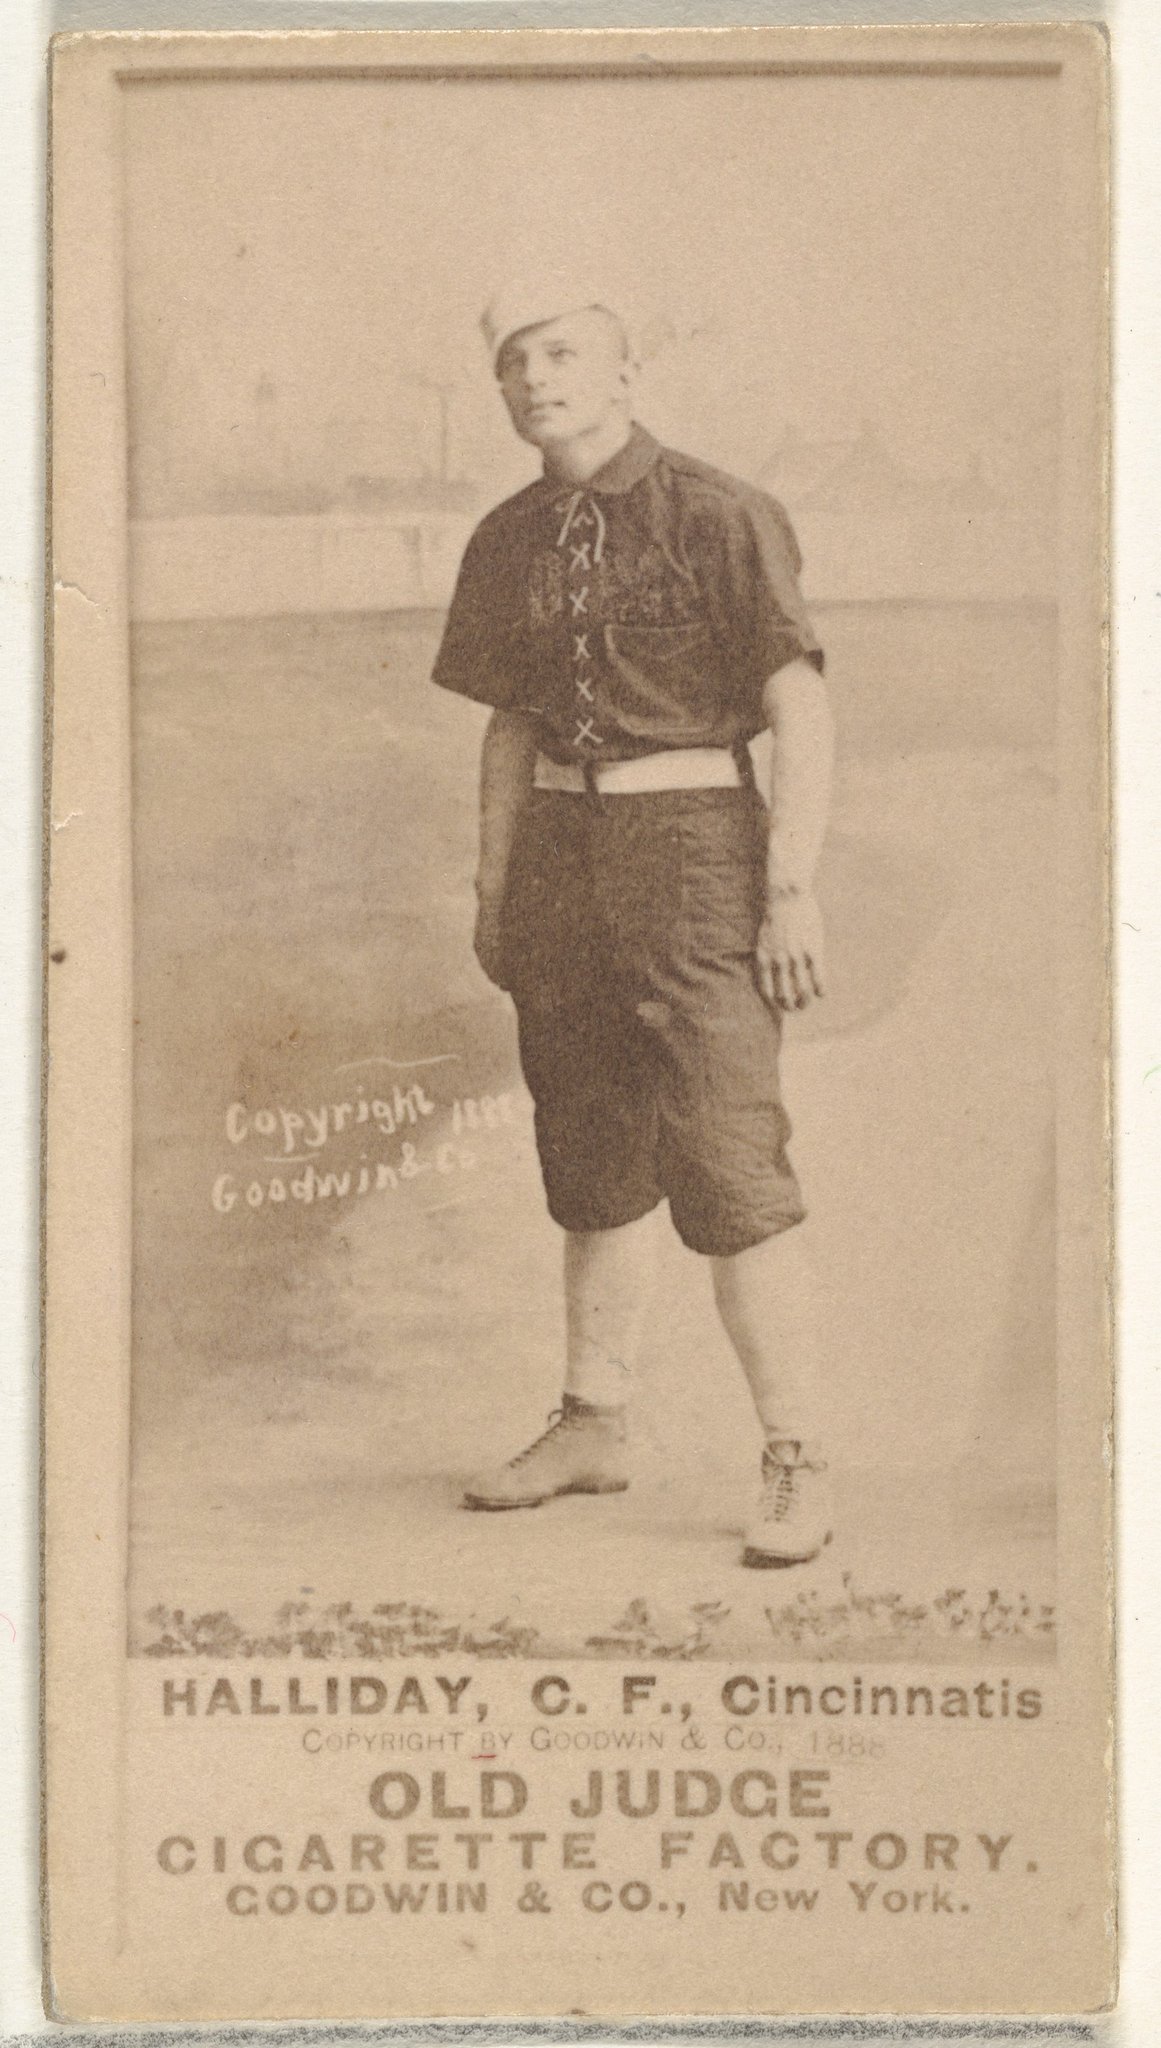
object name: baseball card, photograph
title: James Wear "Bug" Holliday, Center Field, Cincinnati, from the Old Judge series (N172) for Old Judge Cigarettes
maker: goodwin & company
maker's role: publisher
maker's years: 1850-1950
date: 1888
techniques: albumen silver print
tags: men,portraits,baseball,athletes